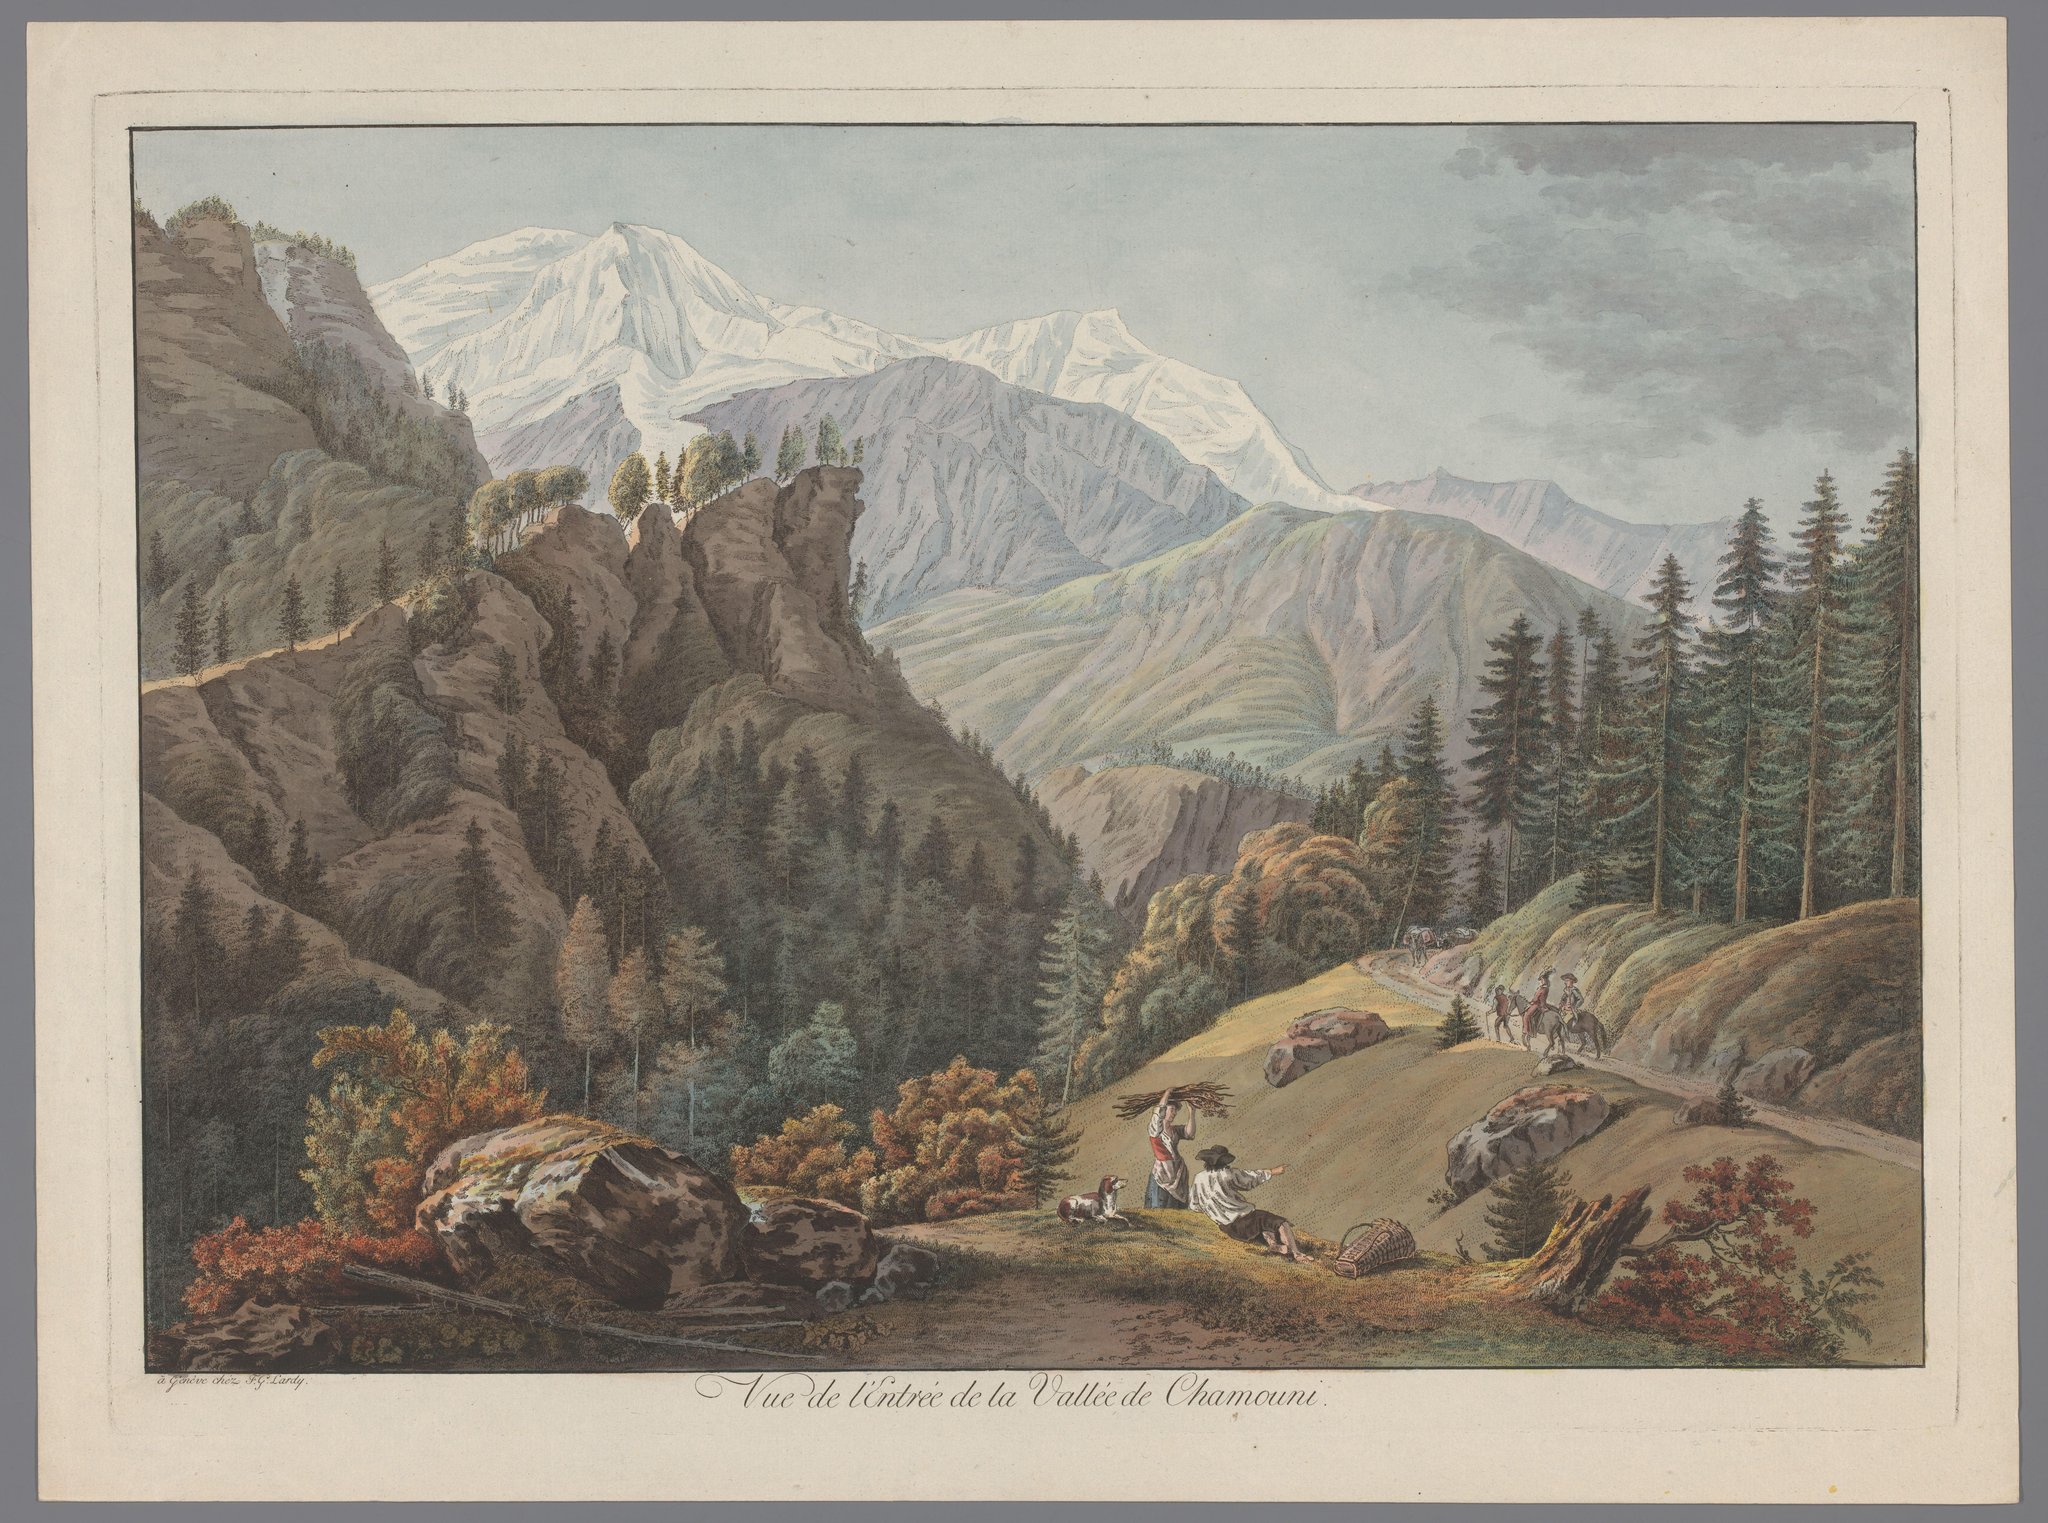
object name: print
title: Vue de l'Entrée de la Vallée de Chamouni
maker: françois guillaume lardy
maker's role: print maker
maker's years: 1749-1812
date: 1759-1812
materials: paper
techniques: etching, hand coloring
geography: geneva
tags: dale, valley, mountains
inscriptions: collector's mark: Lugt 2233